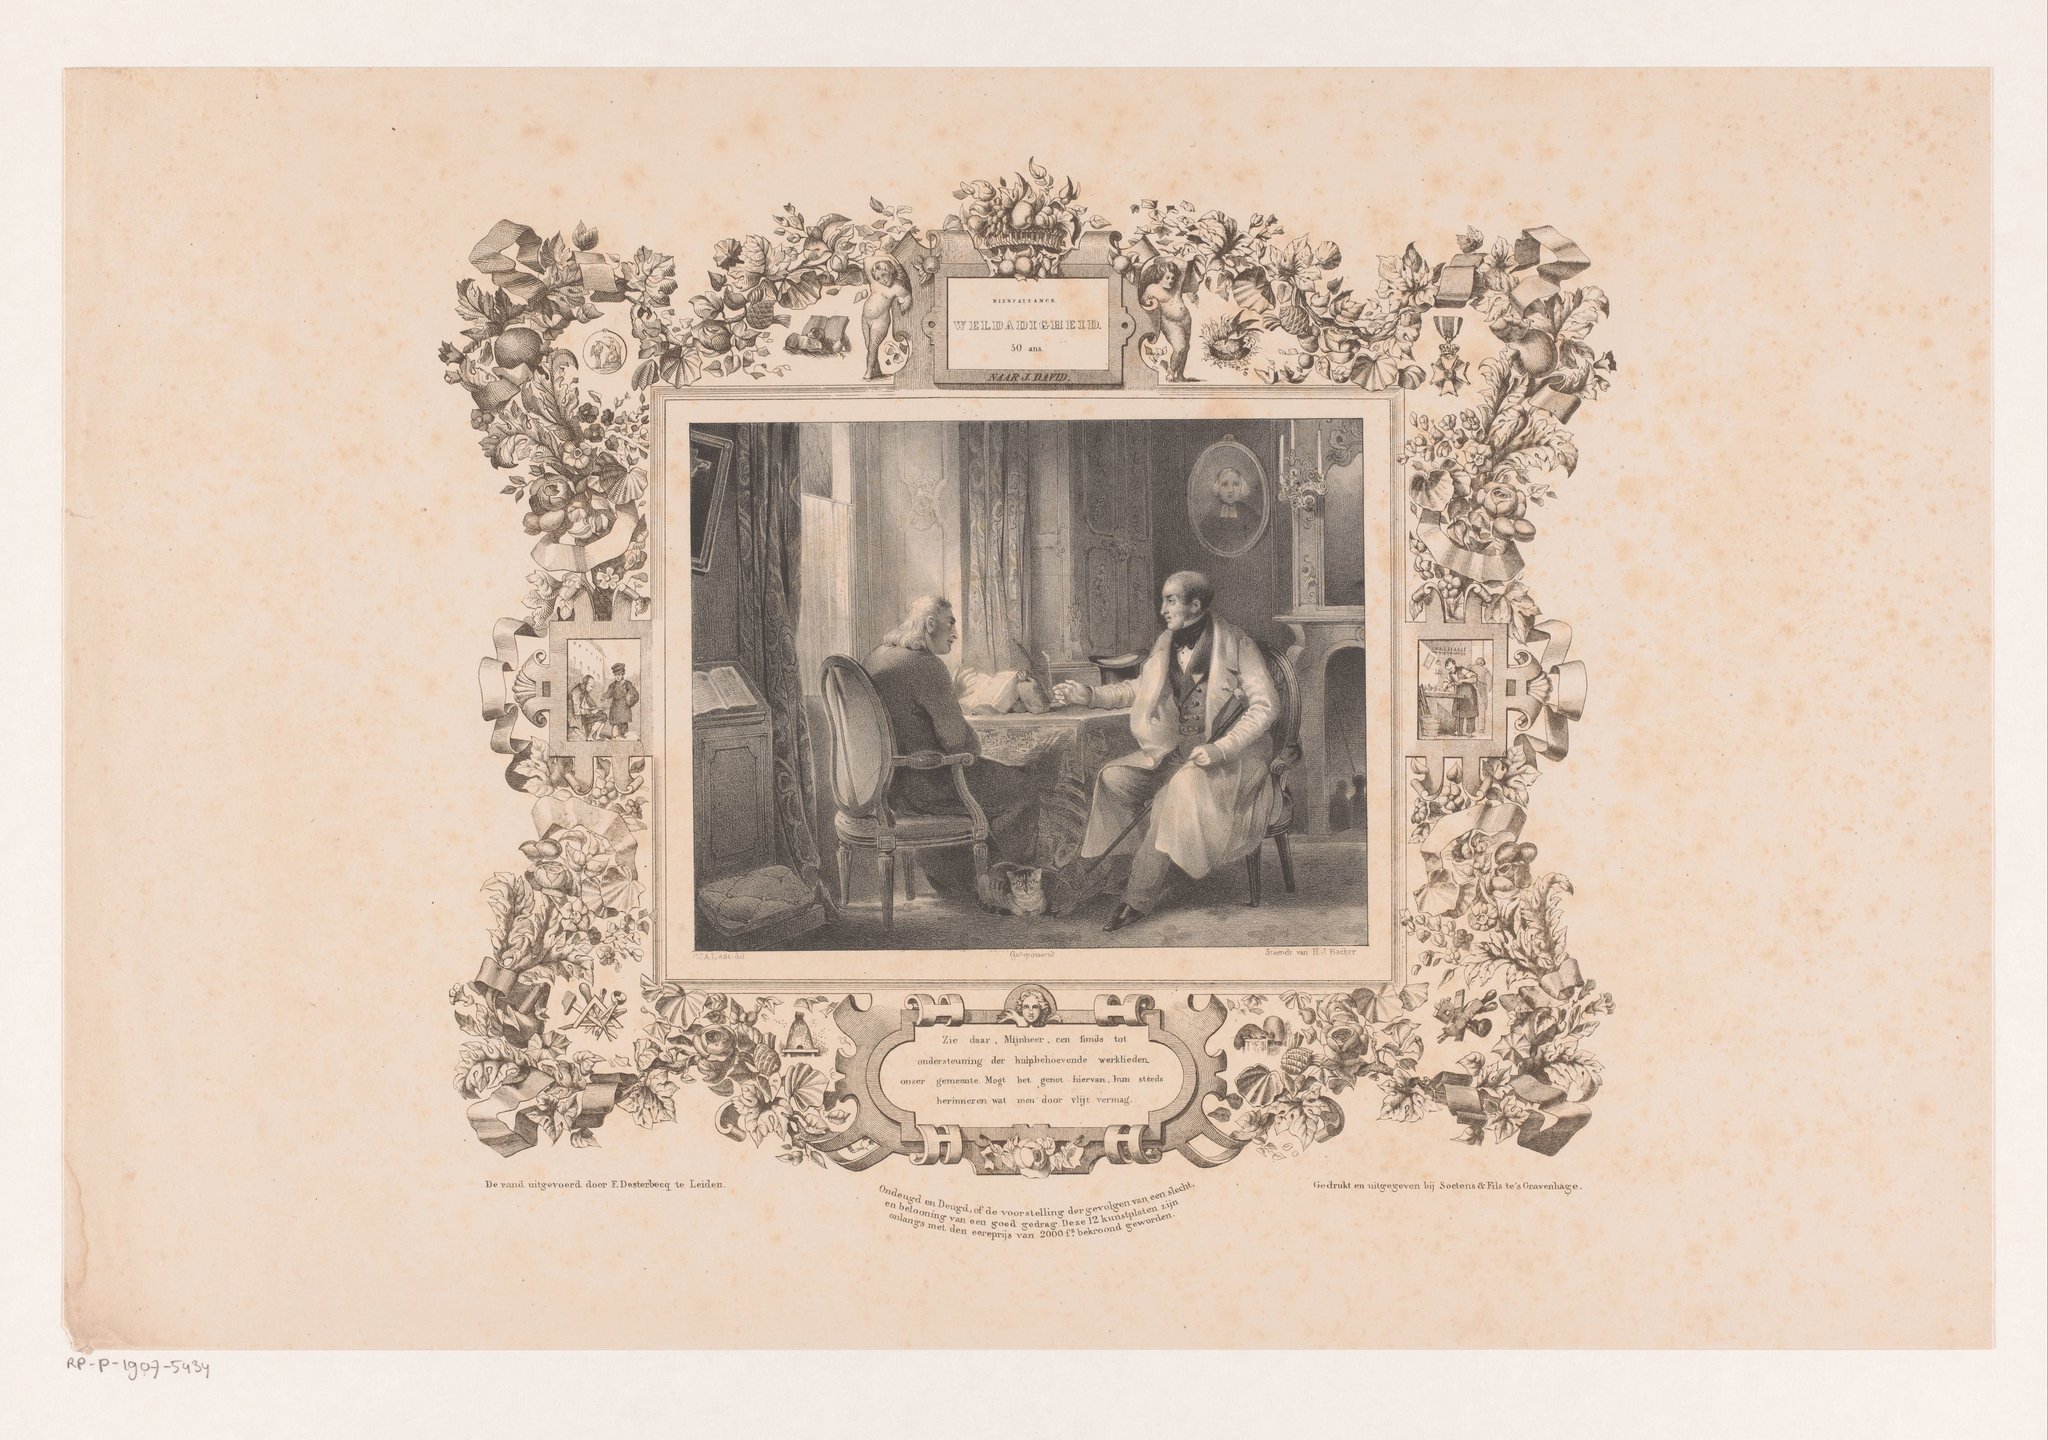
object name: print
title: Bienfaisance / Weldadigheid / 50 ans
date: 1837-1840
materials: paper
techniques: lithograph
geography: the hague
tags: unselfishness (+ situation or event (especially in genre-painting) with symbolical connotation), virtuousness; 'amor di virtù', 'attione virtuosa', 'guida sicura de' veri honori', 'virtù', 'virtù insuperabile' (ripa), giving alms; collection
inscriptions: collector's mark: Lugt 2228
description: In de rand symbolen die verwijzen naar ondeugd zoals een arrestatie, een gevangene en flessen drank.